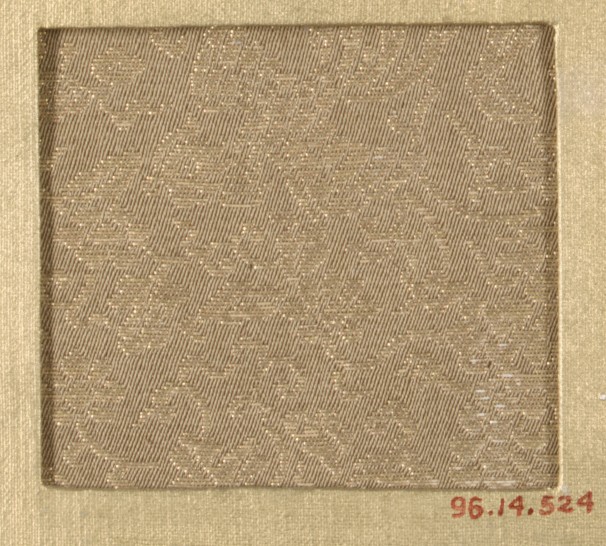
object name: piece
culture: japanese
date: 1701-1900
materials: metal thread, silk